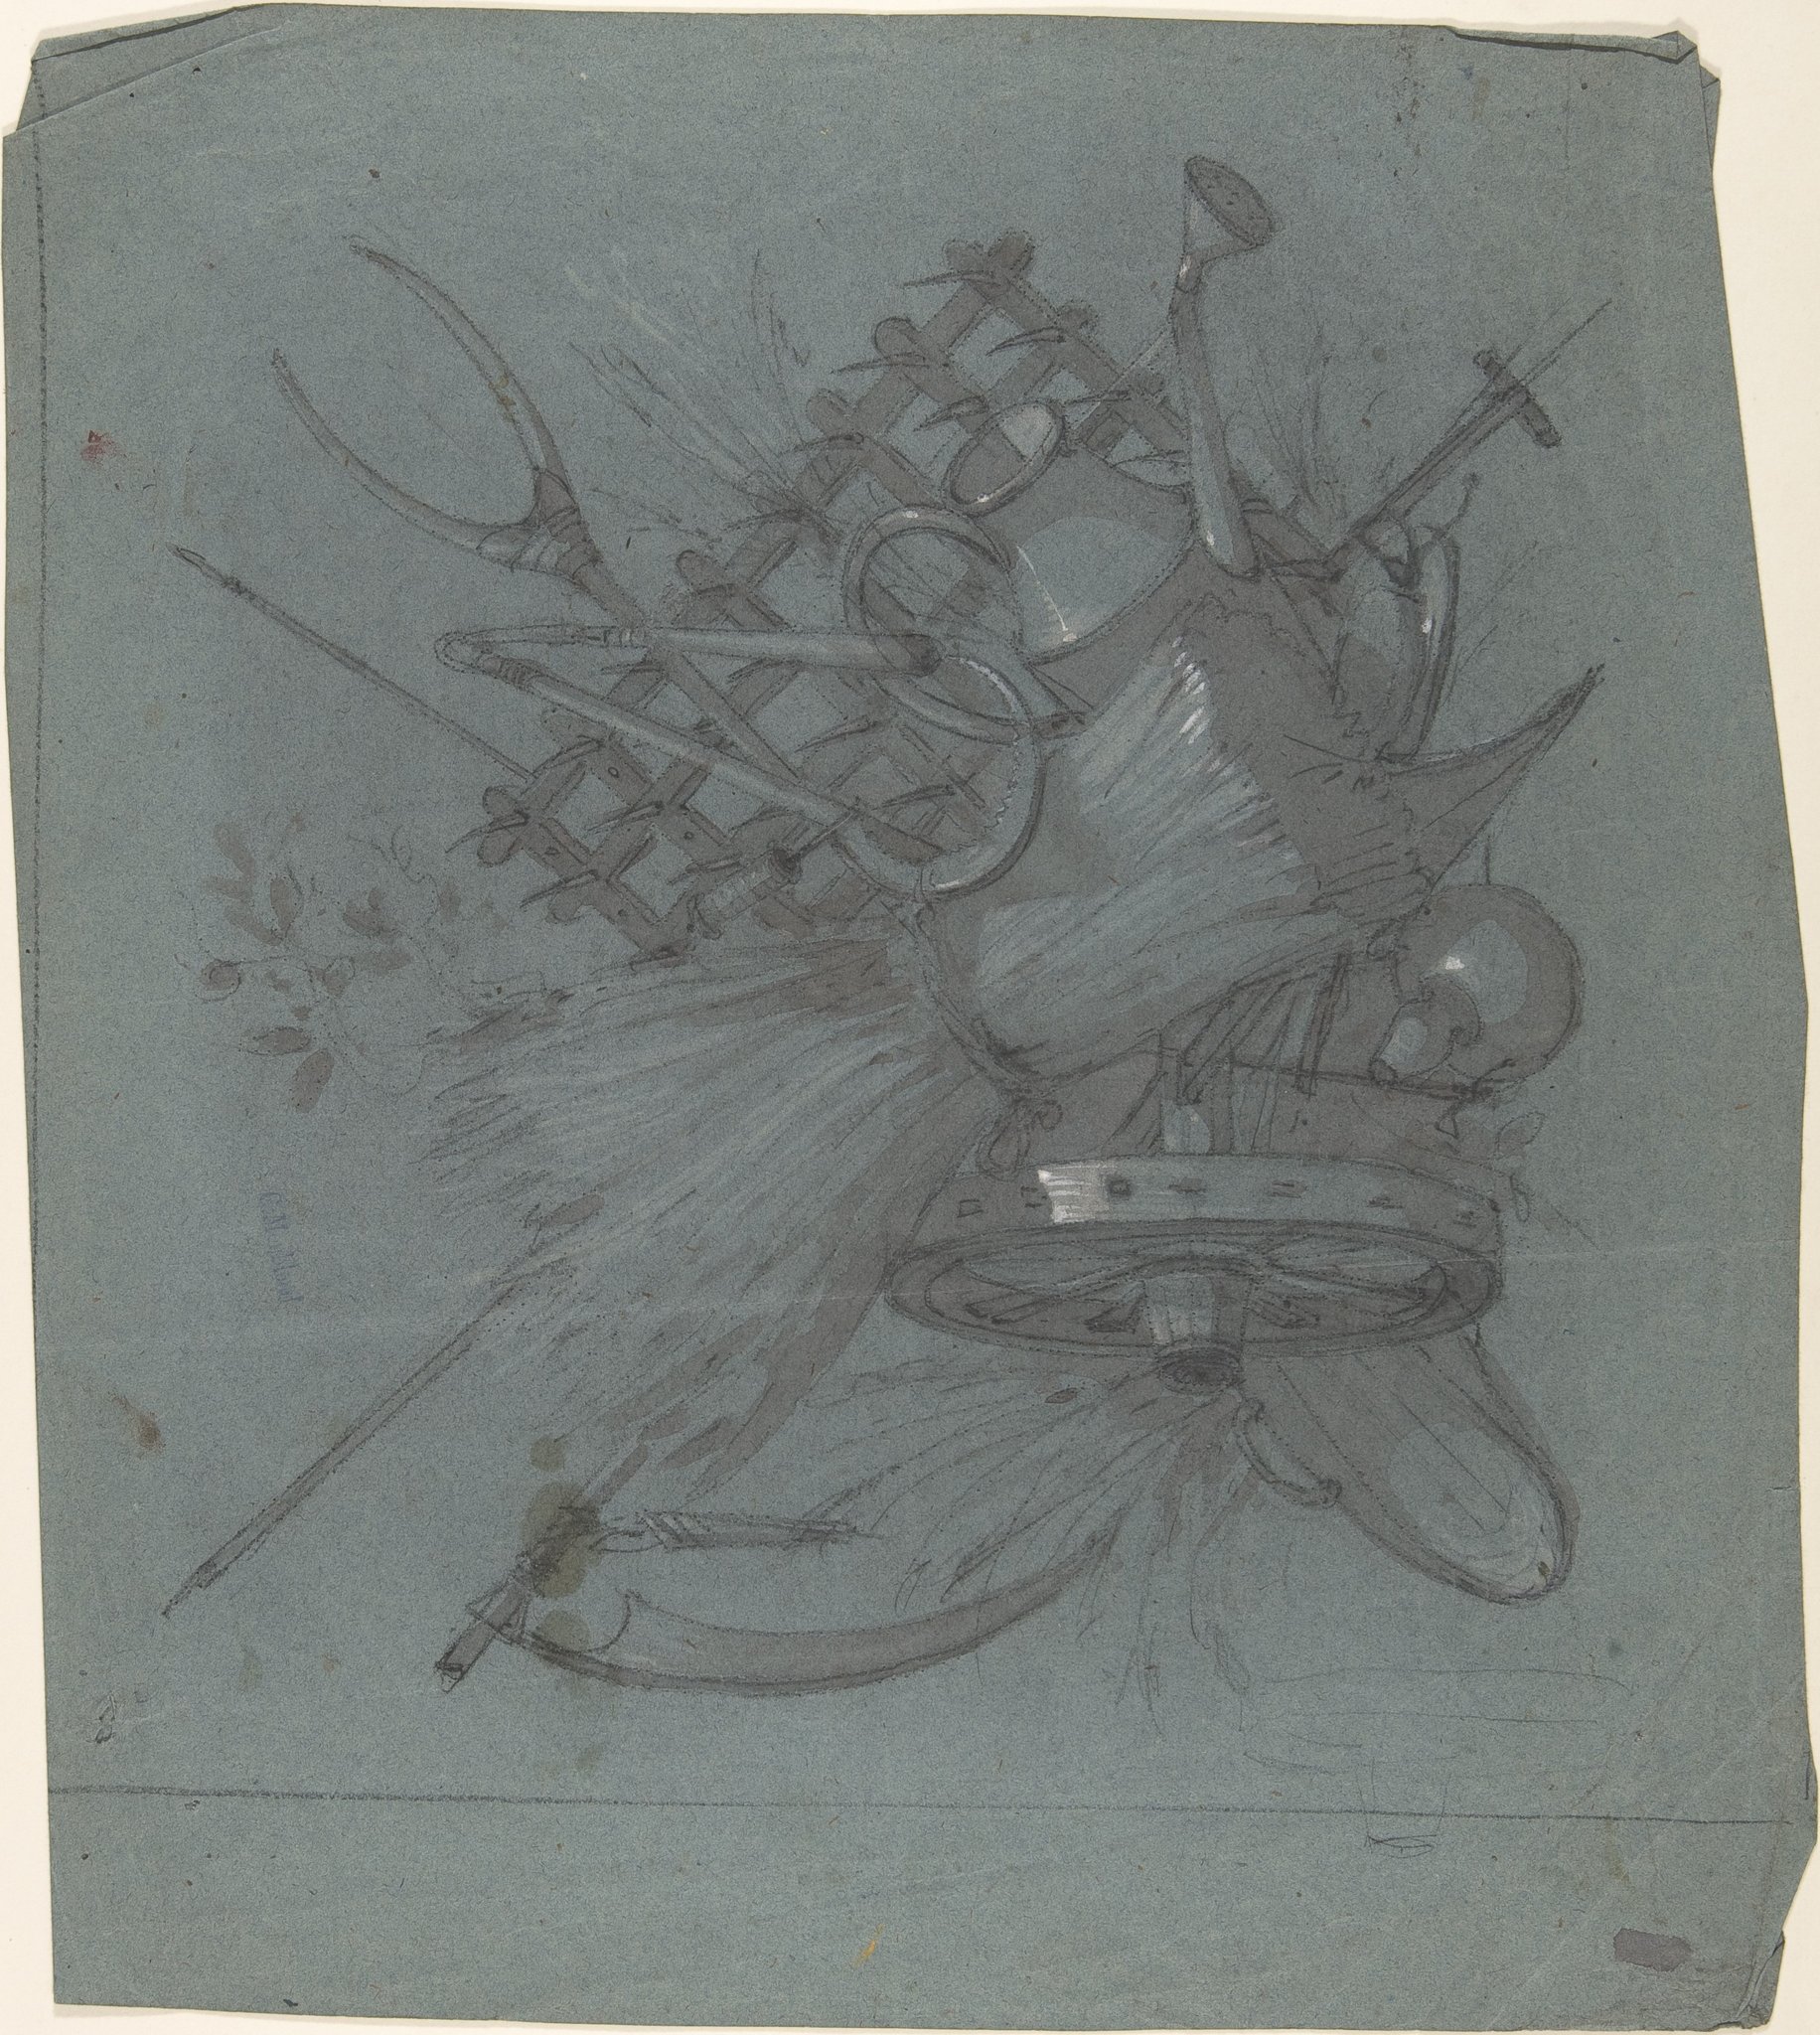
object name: drawing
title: Harvest Trophy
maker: charles monblond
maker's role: artist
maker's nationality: french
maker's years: 1800-1900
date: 1801-1900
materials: chalk, ink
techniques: brush, heightening, pen, transfer, wash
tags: trophies